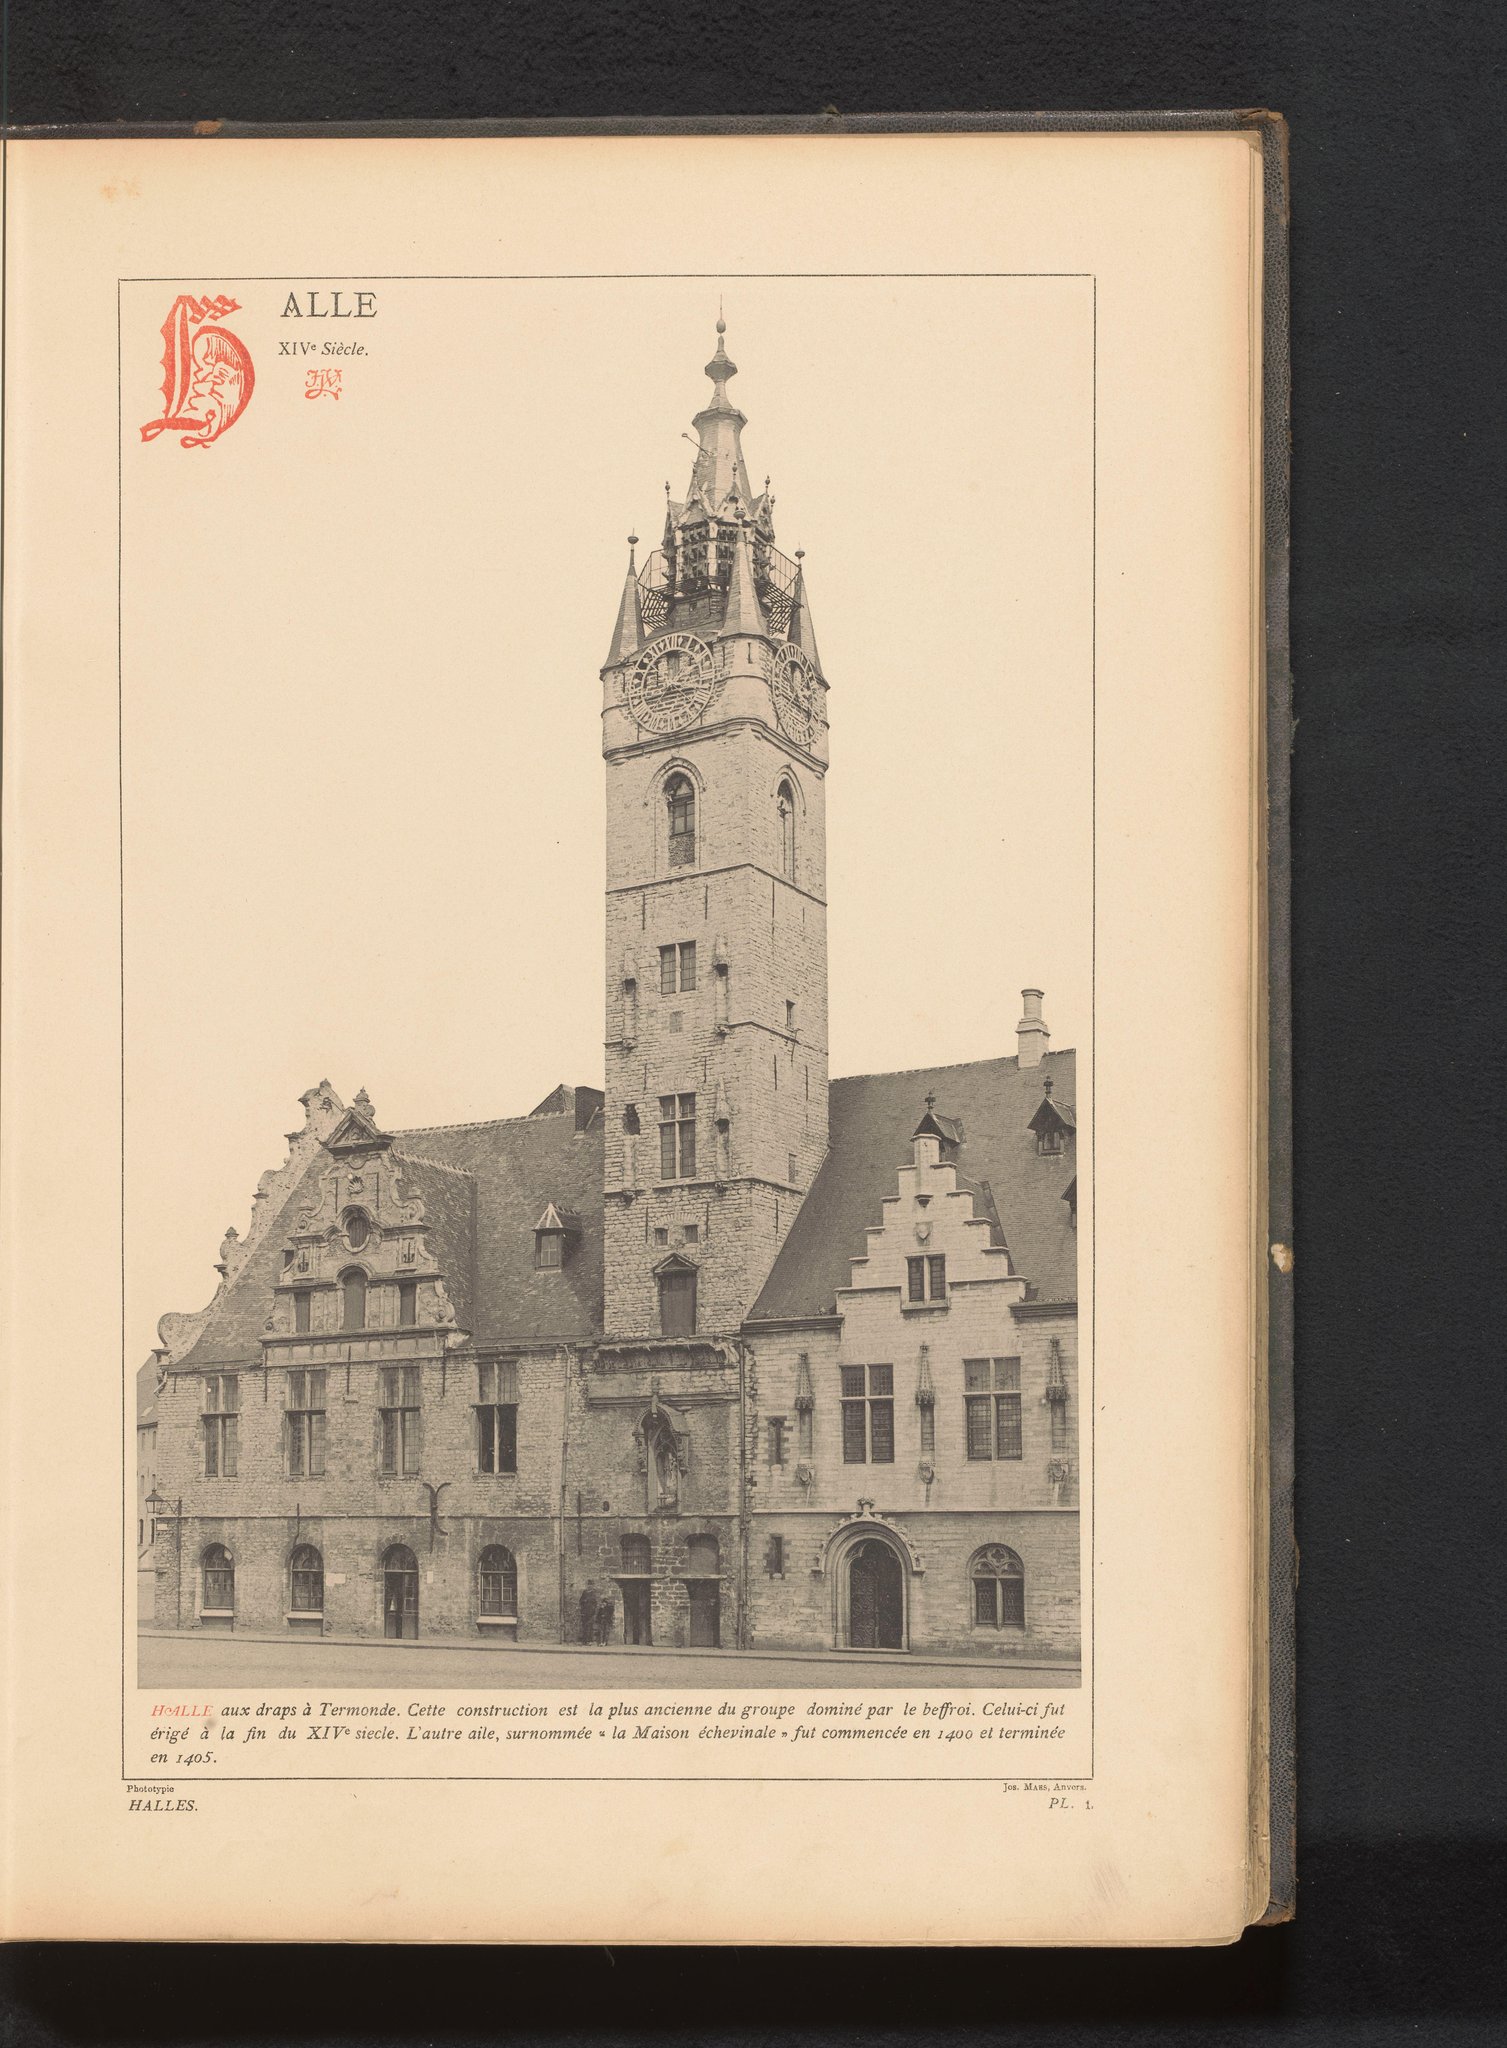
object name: page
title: Halle, XIVe Siècle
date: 1881-1889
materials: paper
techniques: photograph, photolithography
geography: antwerp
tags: townhall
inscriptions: inscription: ‘Halle aux draps (...)’, inscription: ‘HALLES. PL. 1.’, monogram: ‘JJvY’